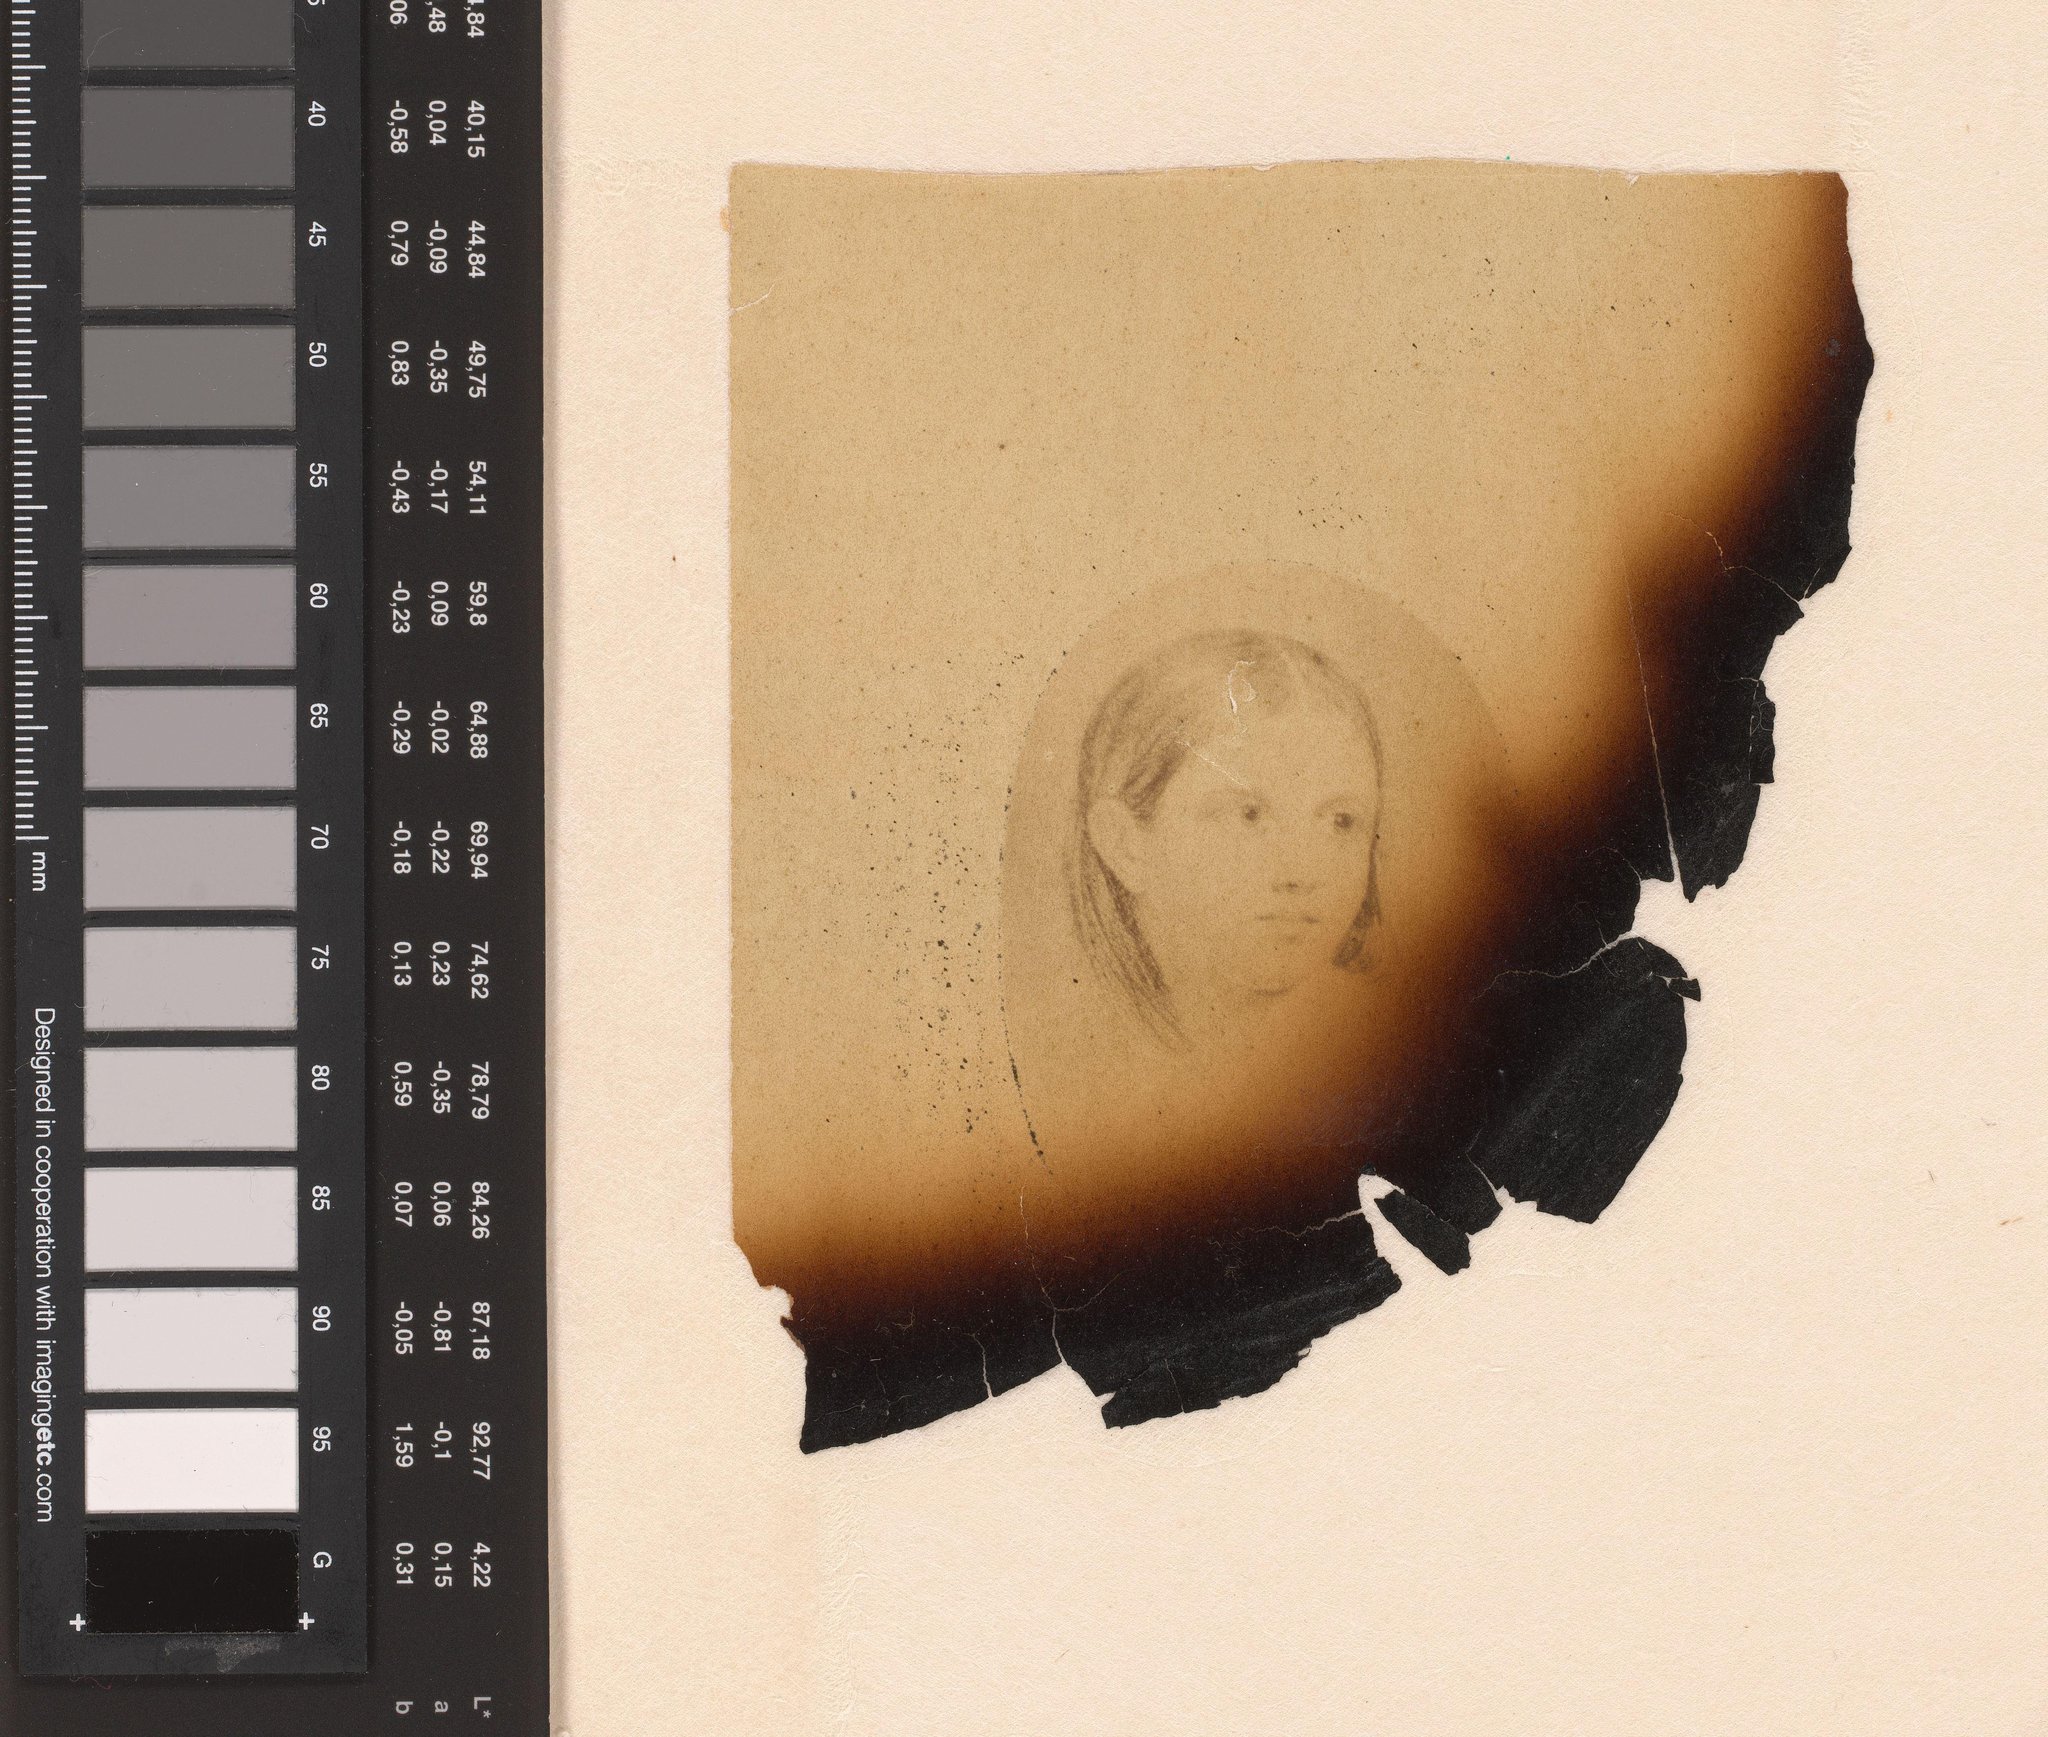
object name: reproduction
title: Ovaal portret van jong blank meisje (reproductie)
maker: antoon bauduin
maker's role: amateurfotograaf, hoogleraar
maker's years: 1820-1885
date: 1862-1866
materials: paper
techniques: albumen print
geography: japan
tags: historical persons not known by name - bb - woman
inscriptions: number: ‘No. 8’